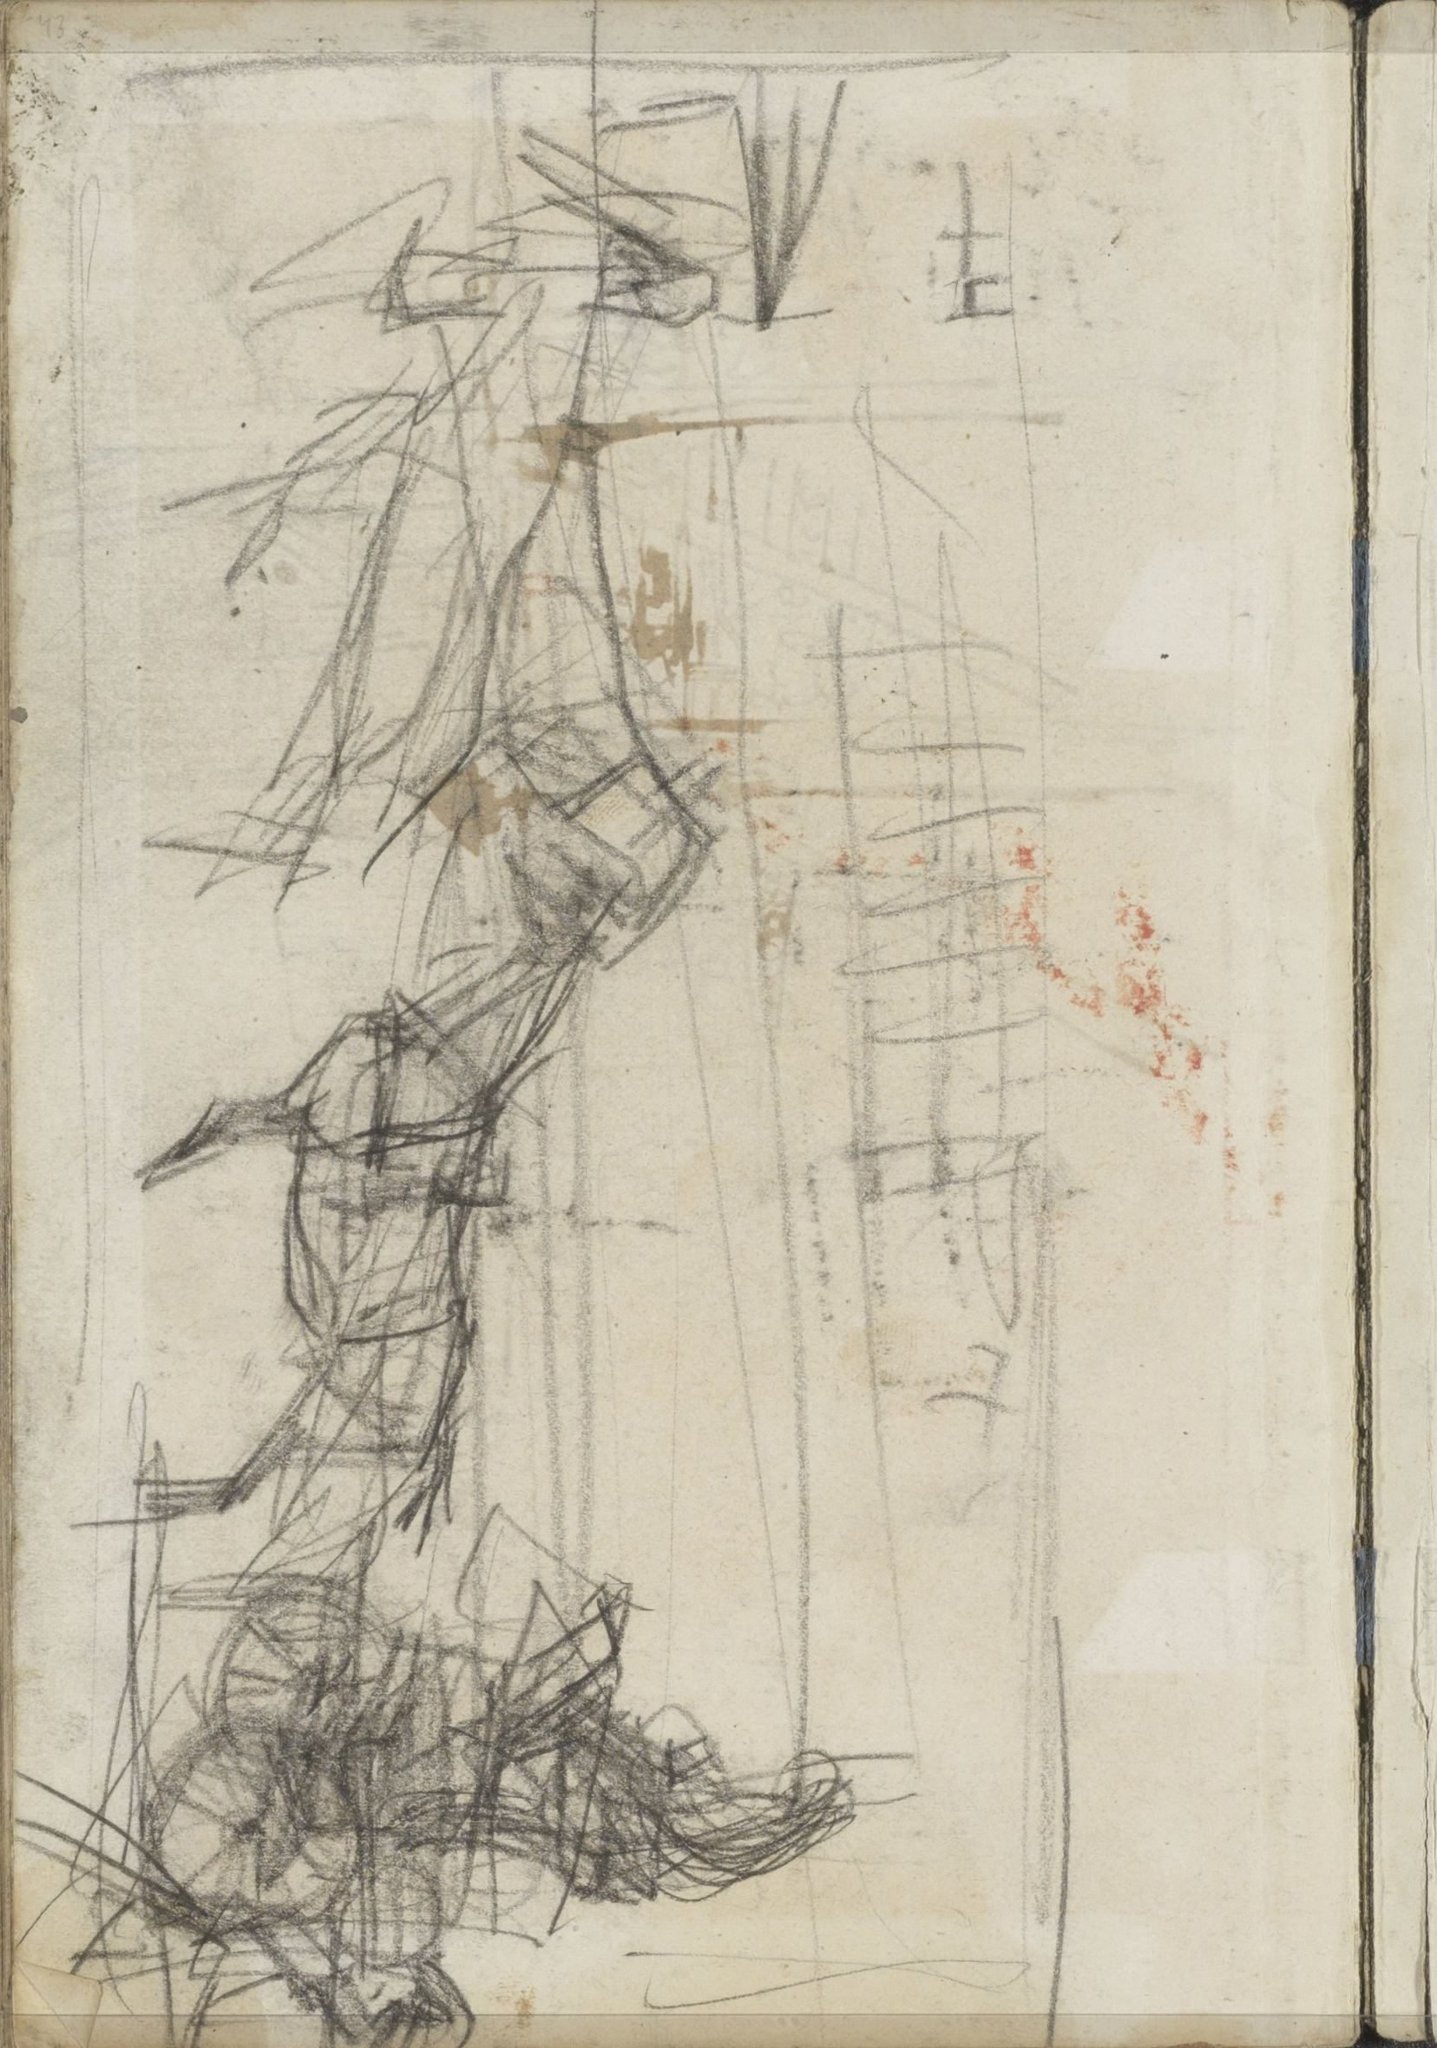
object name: sketchbook leaf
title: Figuur op een paard-en-wagen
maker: george hendrik breitner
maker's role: draughtsman, painter, print maker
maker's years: 1857-1923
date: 1895-1898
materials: chalk, paper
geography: amsterdam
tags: (farm) wagon, freight wagon, cart (+ one person ~ traffic and transport)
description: Pagina 43 uit een schetsboek met 21 bladen.